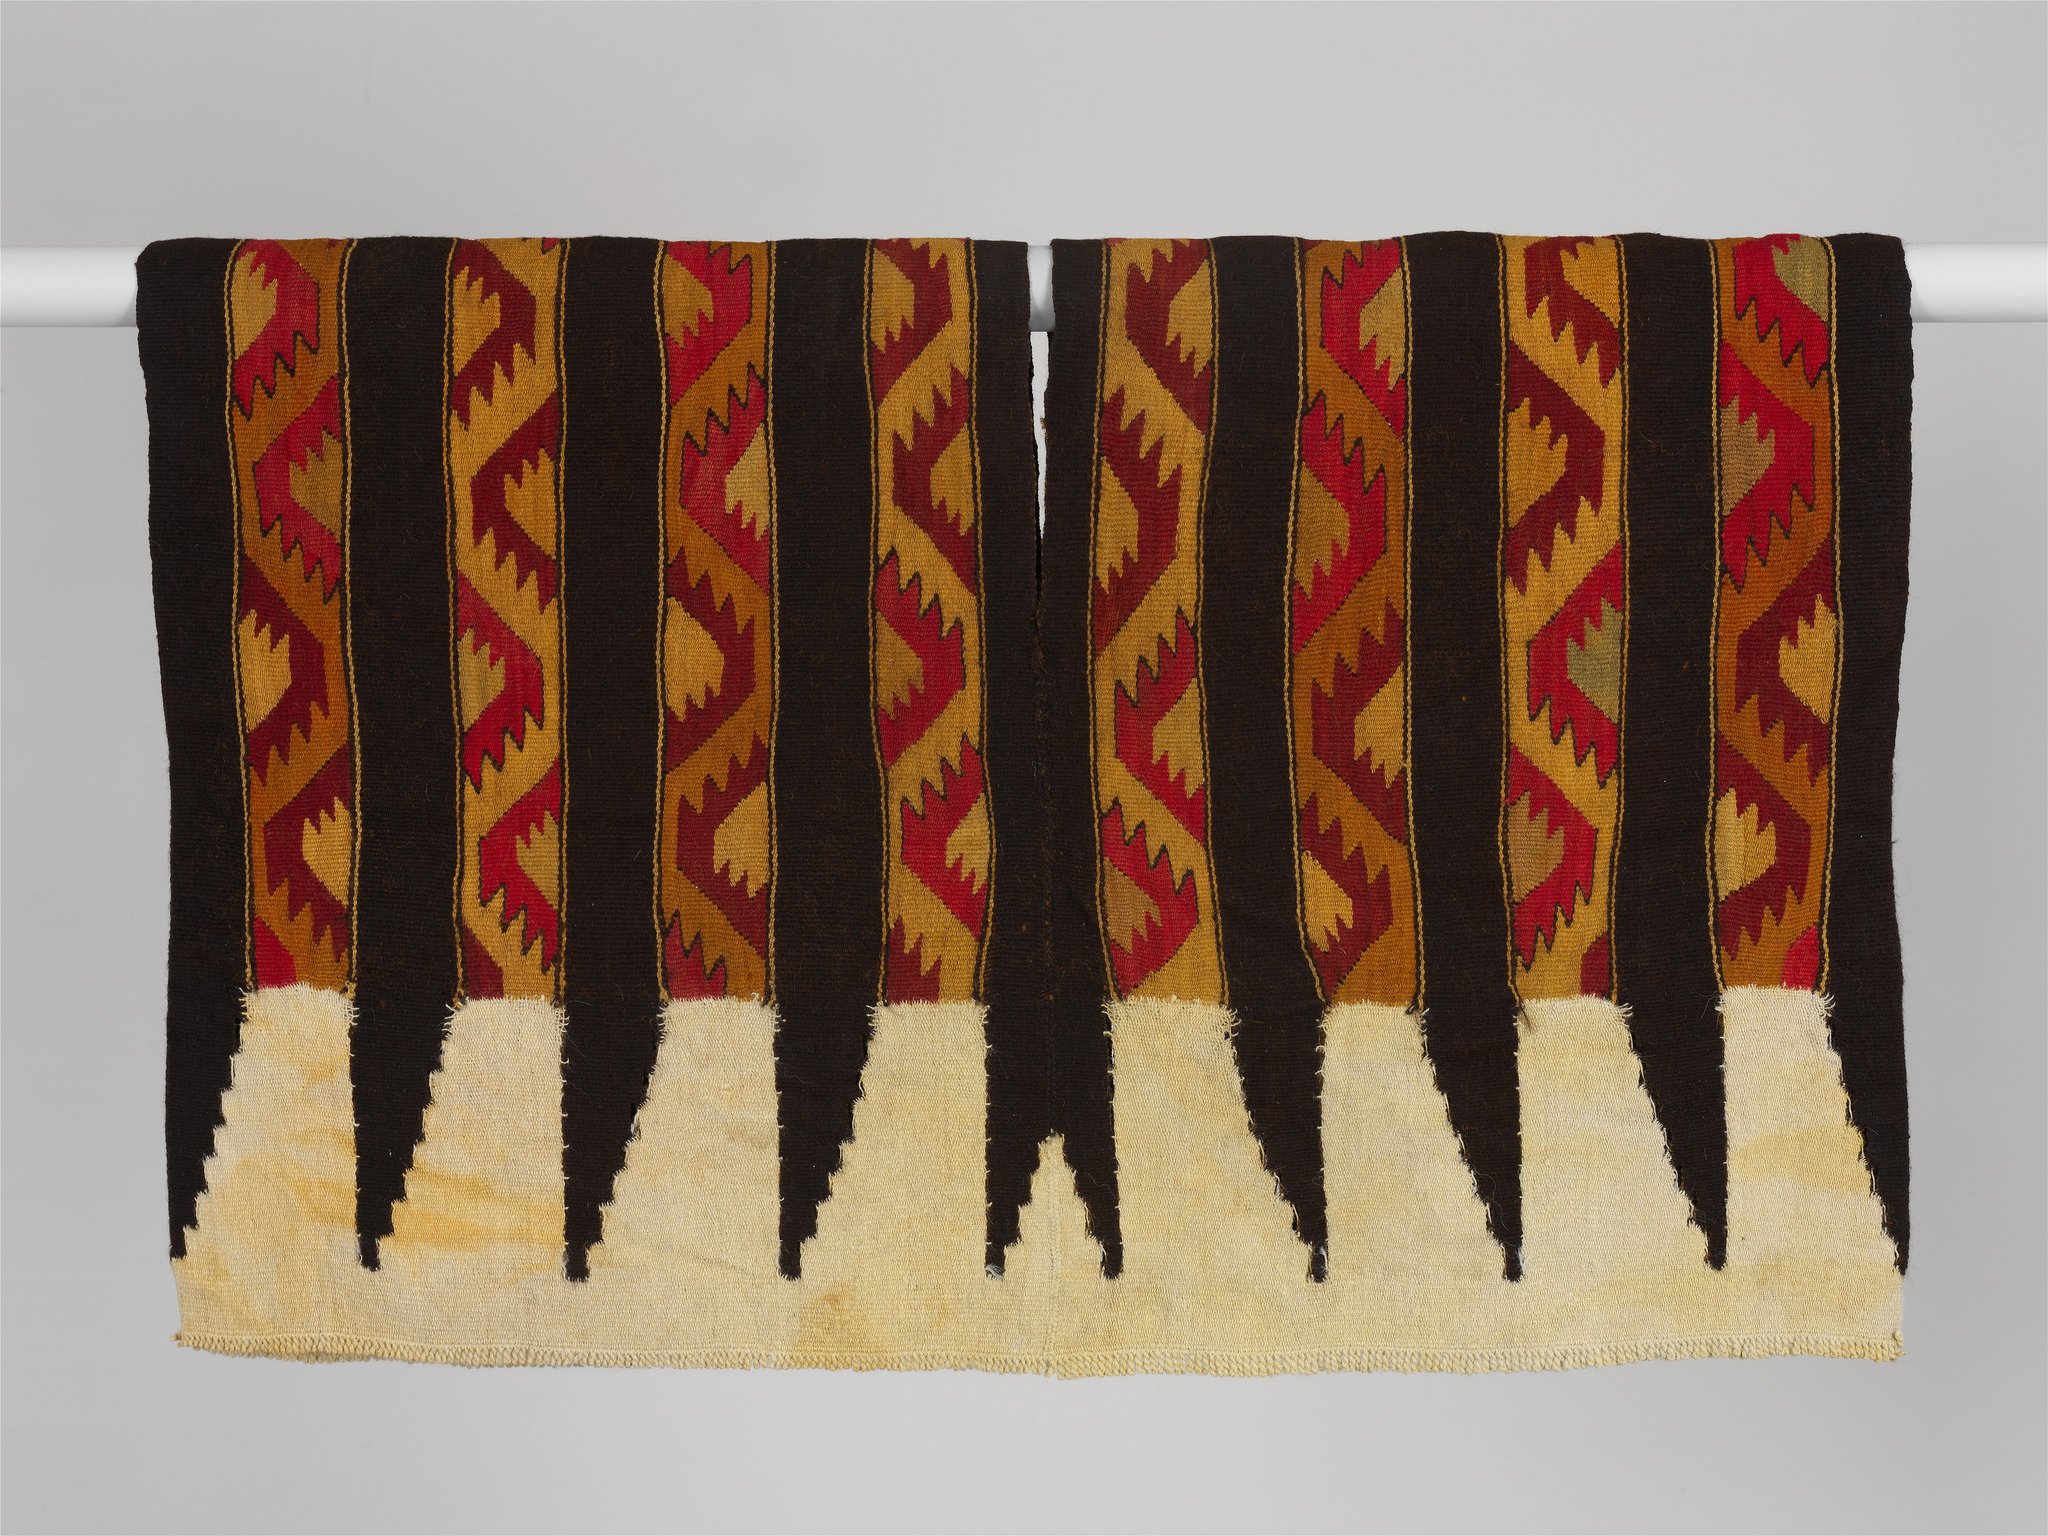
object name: tunic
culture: inca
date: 1450-1550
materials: animal fiber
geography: peru